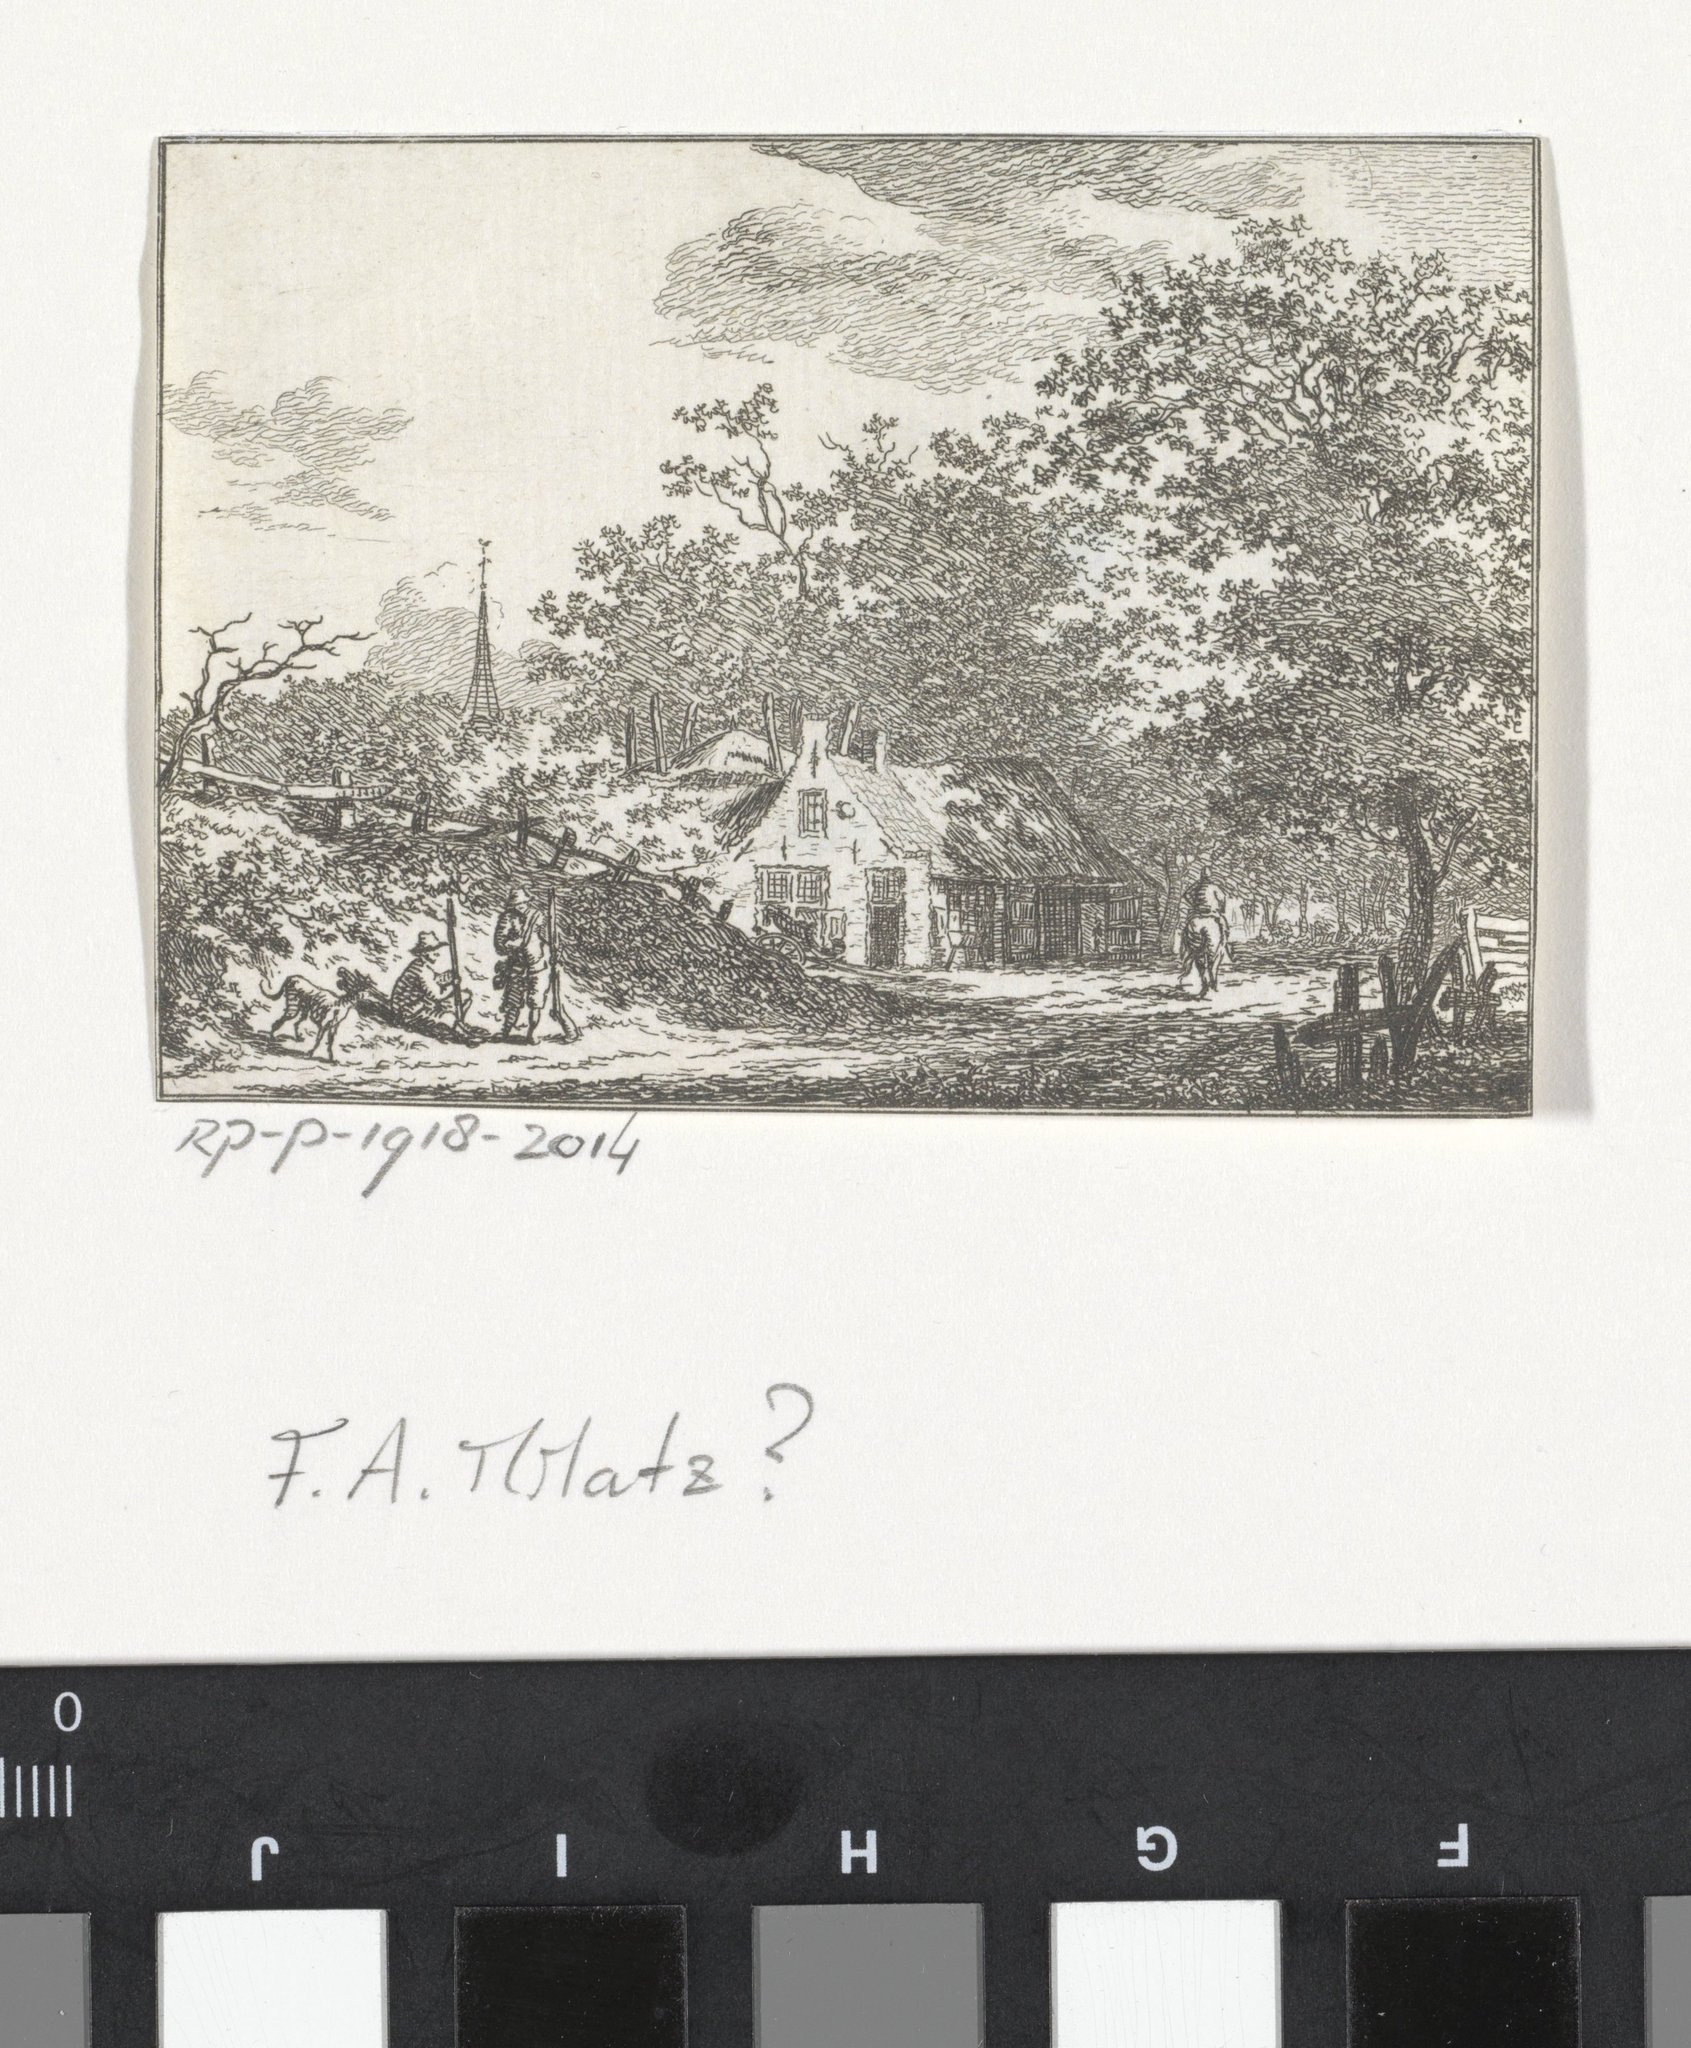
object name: print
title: Rustende jagers langs een weg bij een dorp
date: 1774-1808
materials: paper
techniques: etching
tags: hunter, road, path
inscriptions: collector's mark: Lugt 2233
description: Links twee jagers langs de weg. Aan de weg een huis.